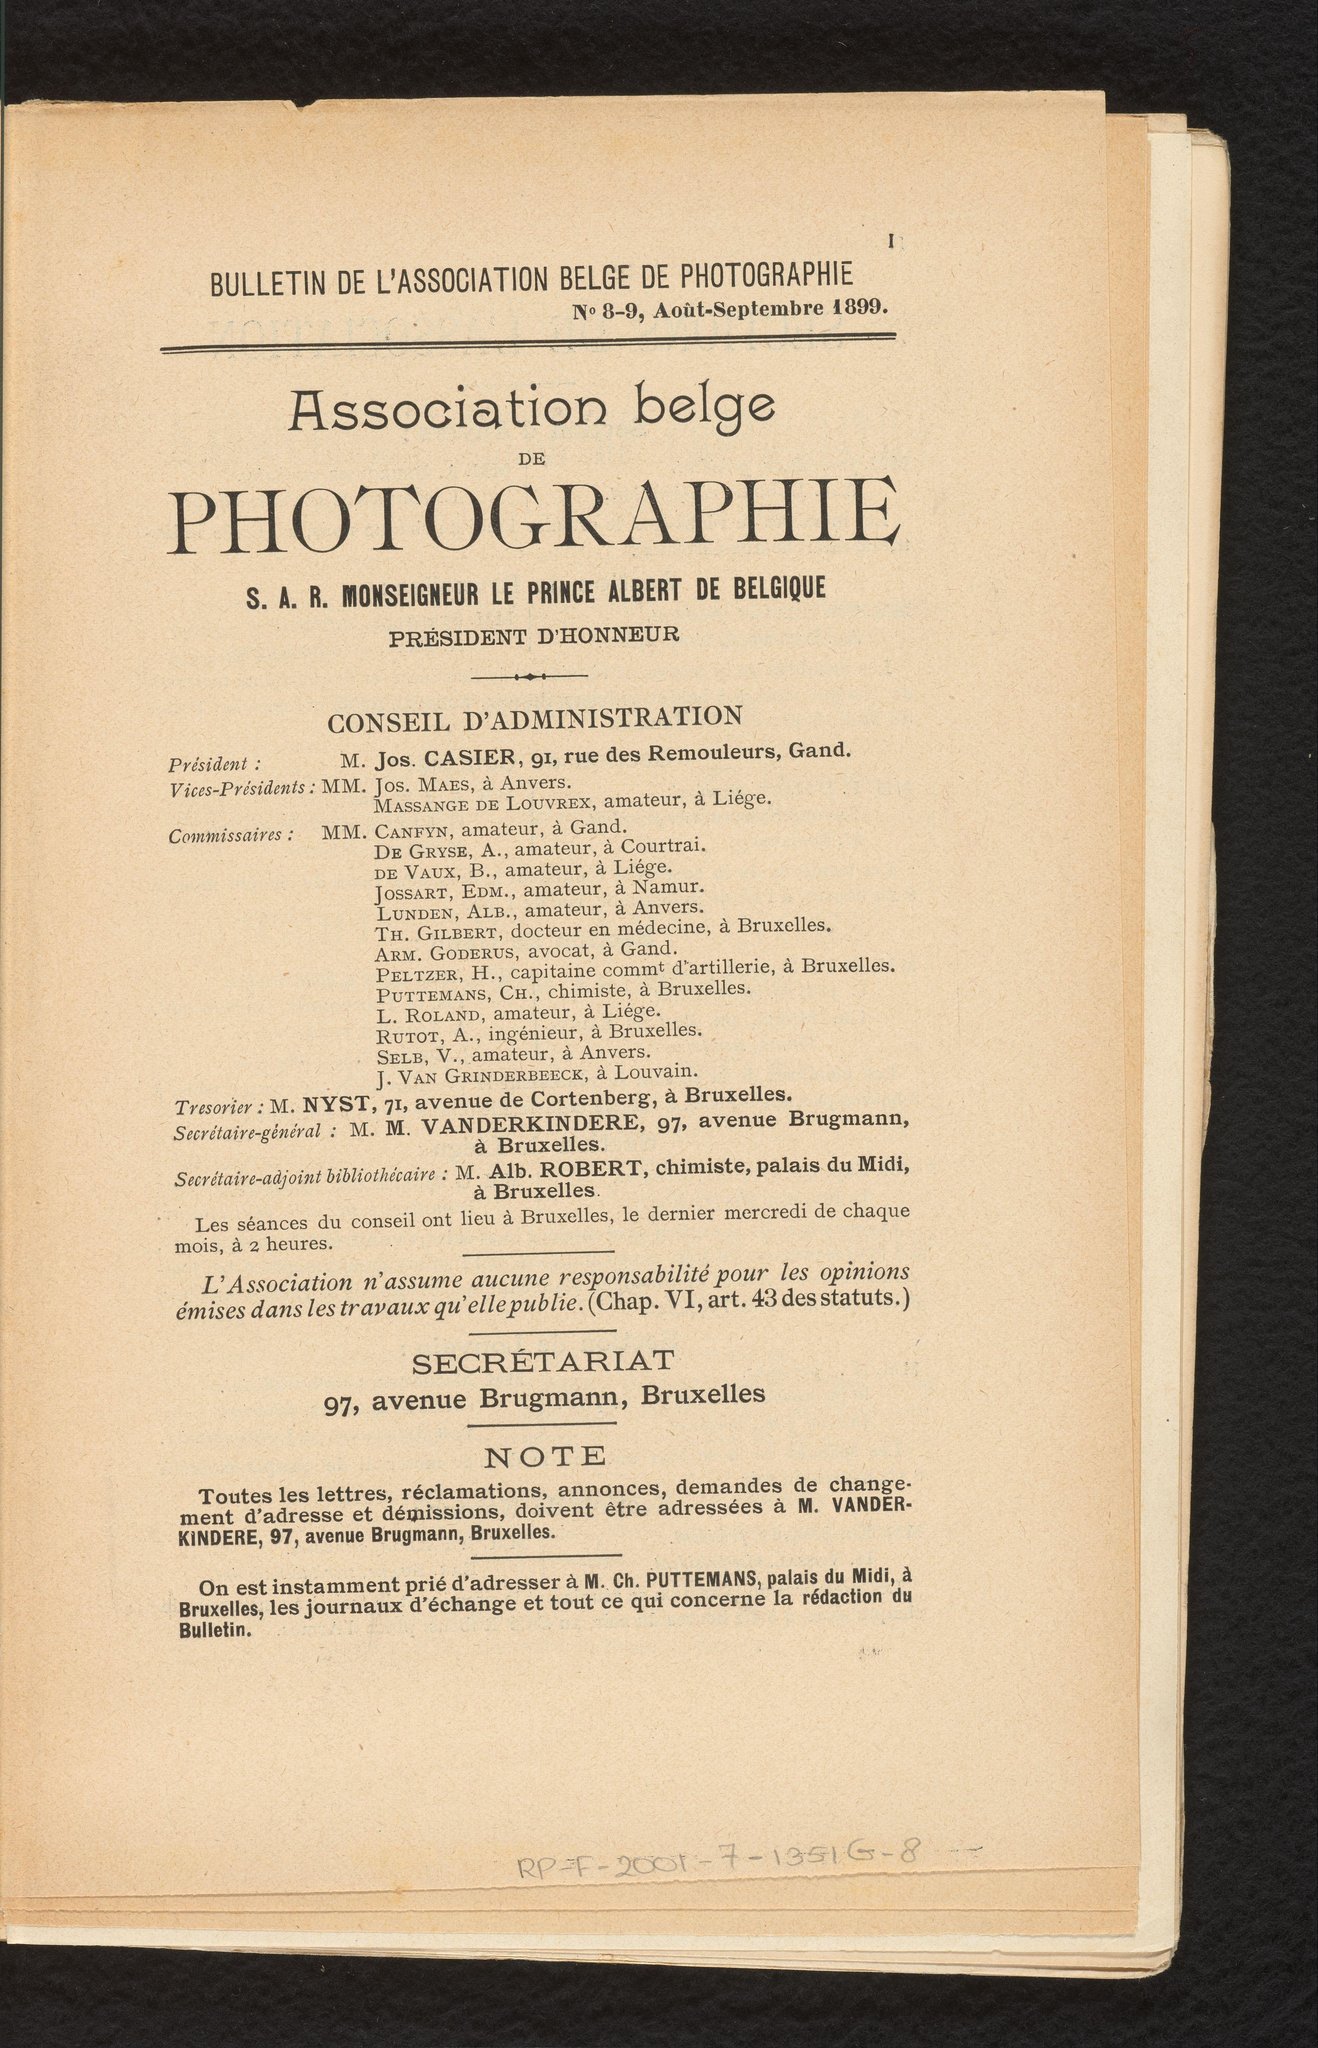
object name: book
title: Bulletin / Association belge de photographie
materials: paper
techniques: photograph, printing, engraving